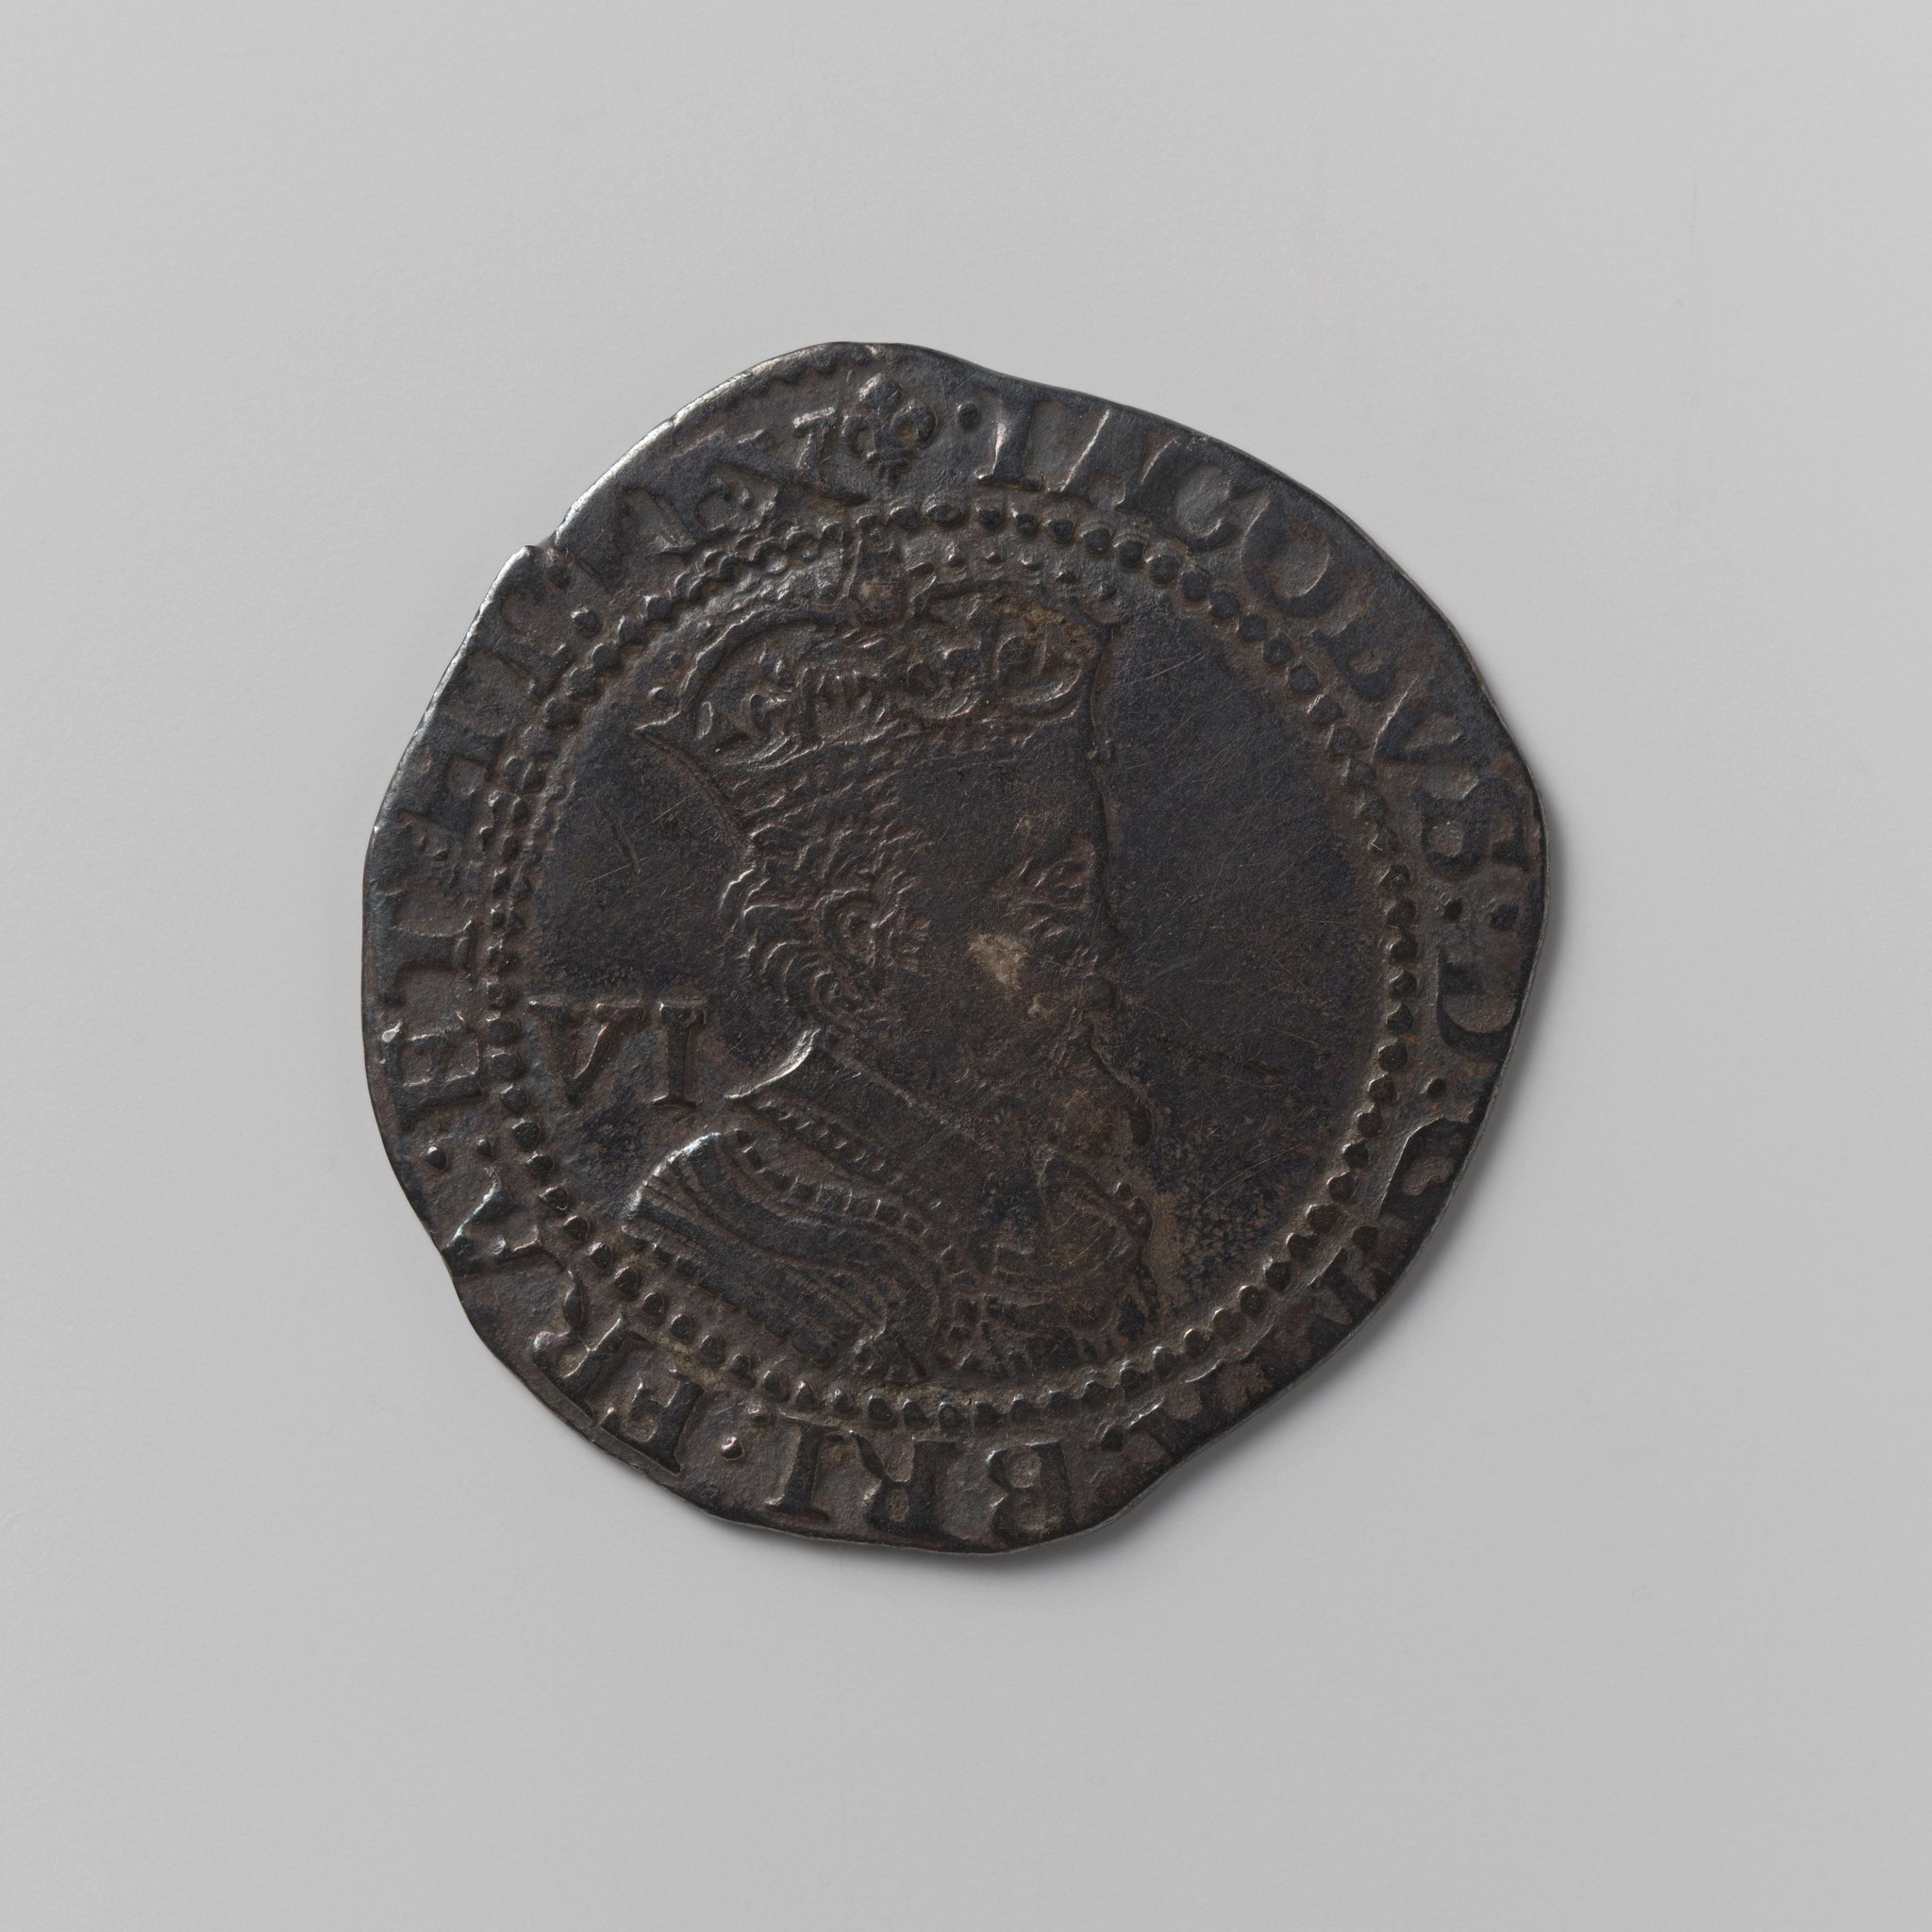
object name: coin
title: Engeland, Jacobus I, six pence, 1624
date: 1624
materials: silver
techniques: striking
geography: london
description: Zilveren munt. Voorzijde: gekroond hoofd van de vorst naar rechts. Links van hem waarde-aanduiding VI. Keerzijde: samengesteld wapenschild, waarboven jaartal.